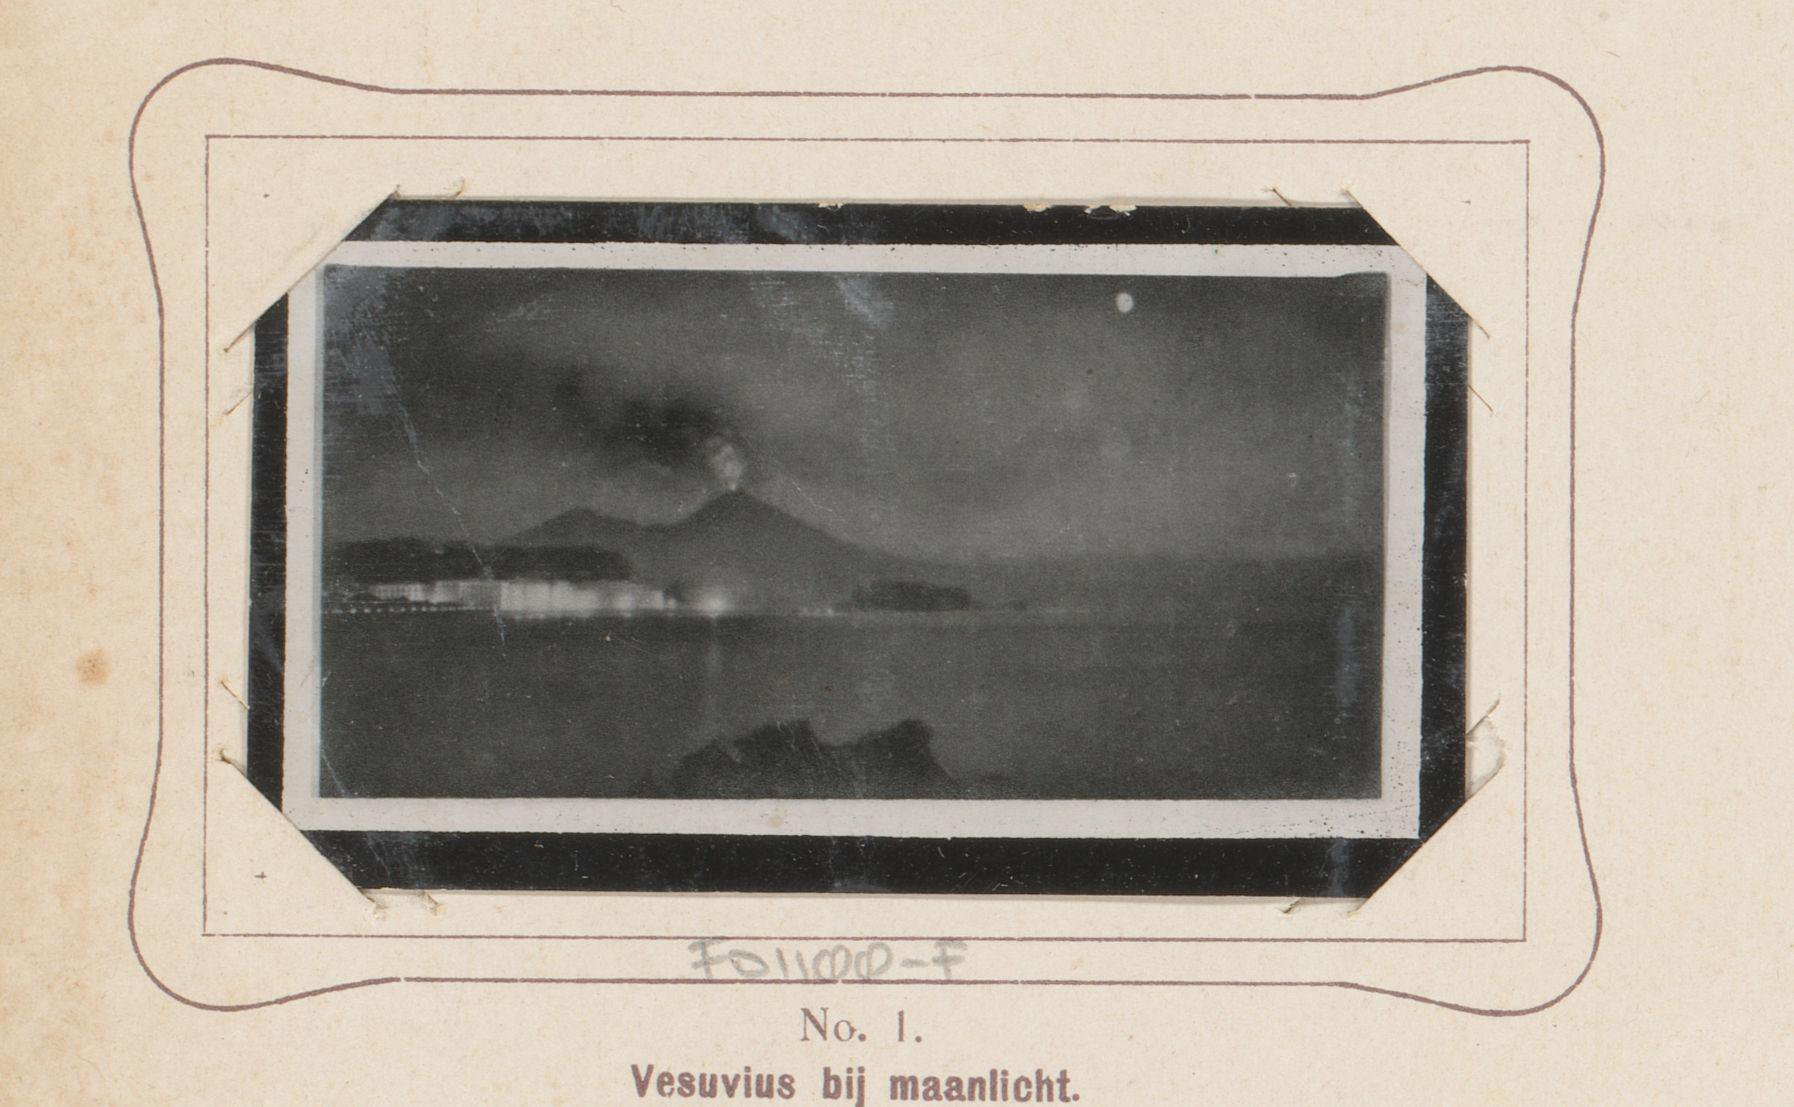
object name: album leaf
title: Gezicht op de Vesuvius bij maanlicht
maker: Anonymous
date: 1906-1907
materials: paper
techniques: photograph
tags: volcano, mount vesuvius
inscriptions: inscription: ‘No. 1./ Vesuvius bij maanlicht.’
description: Deze prent maakt deel uit van een album.